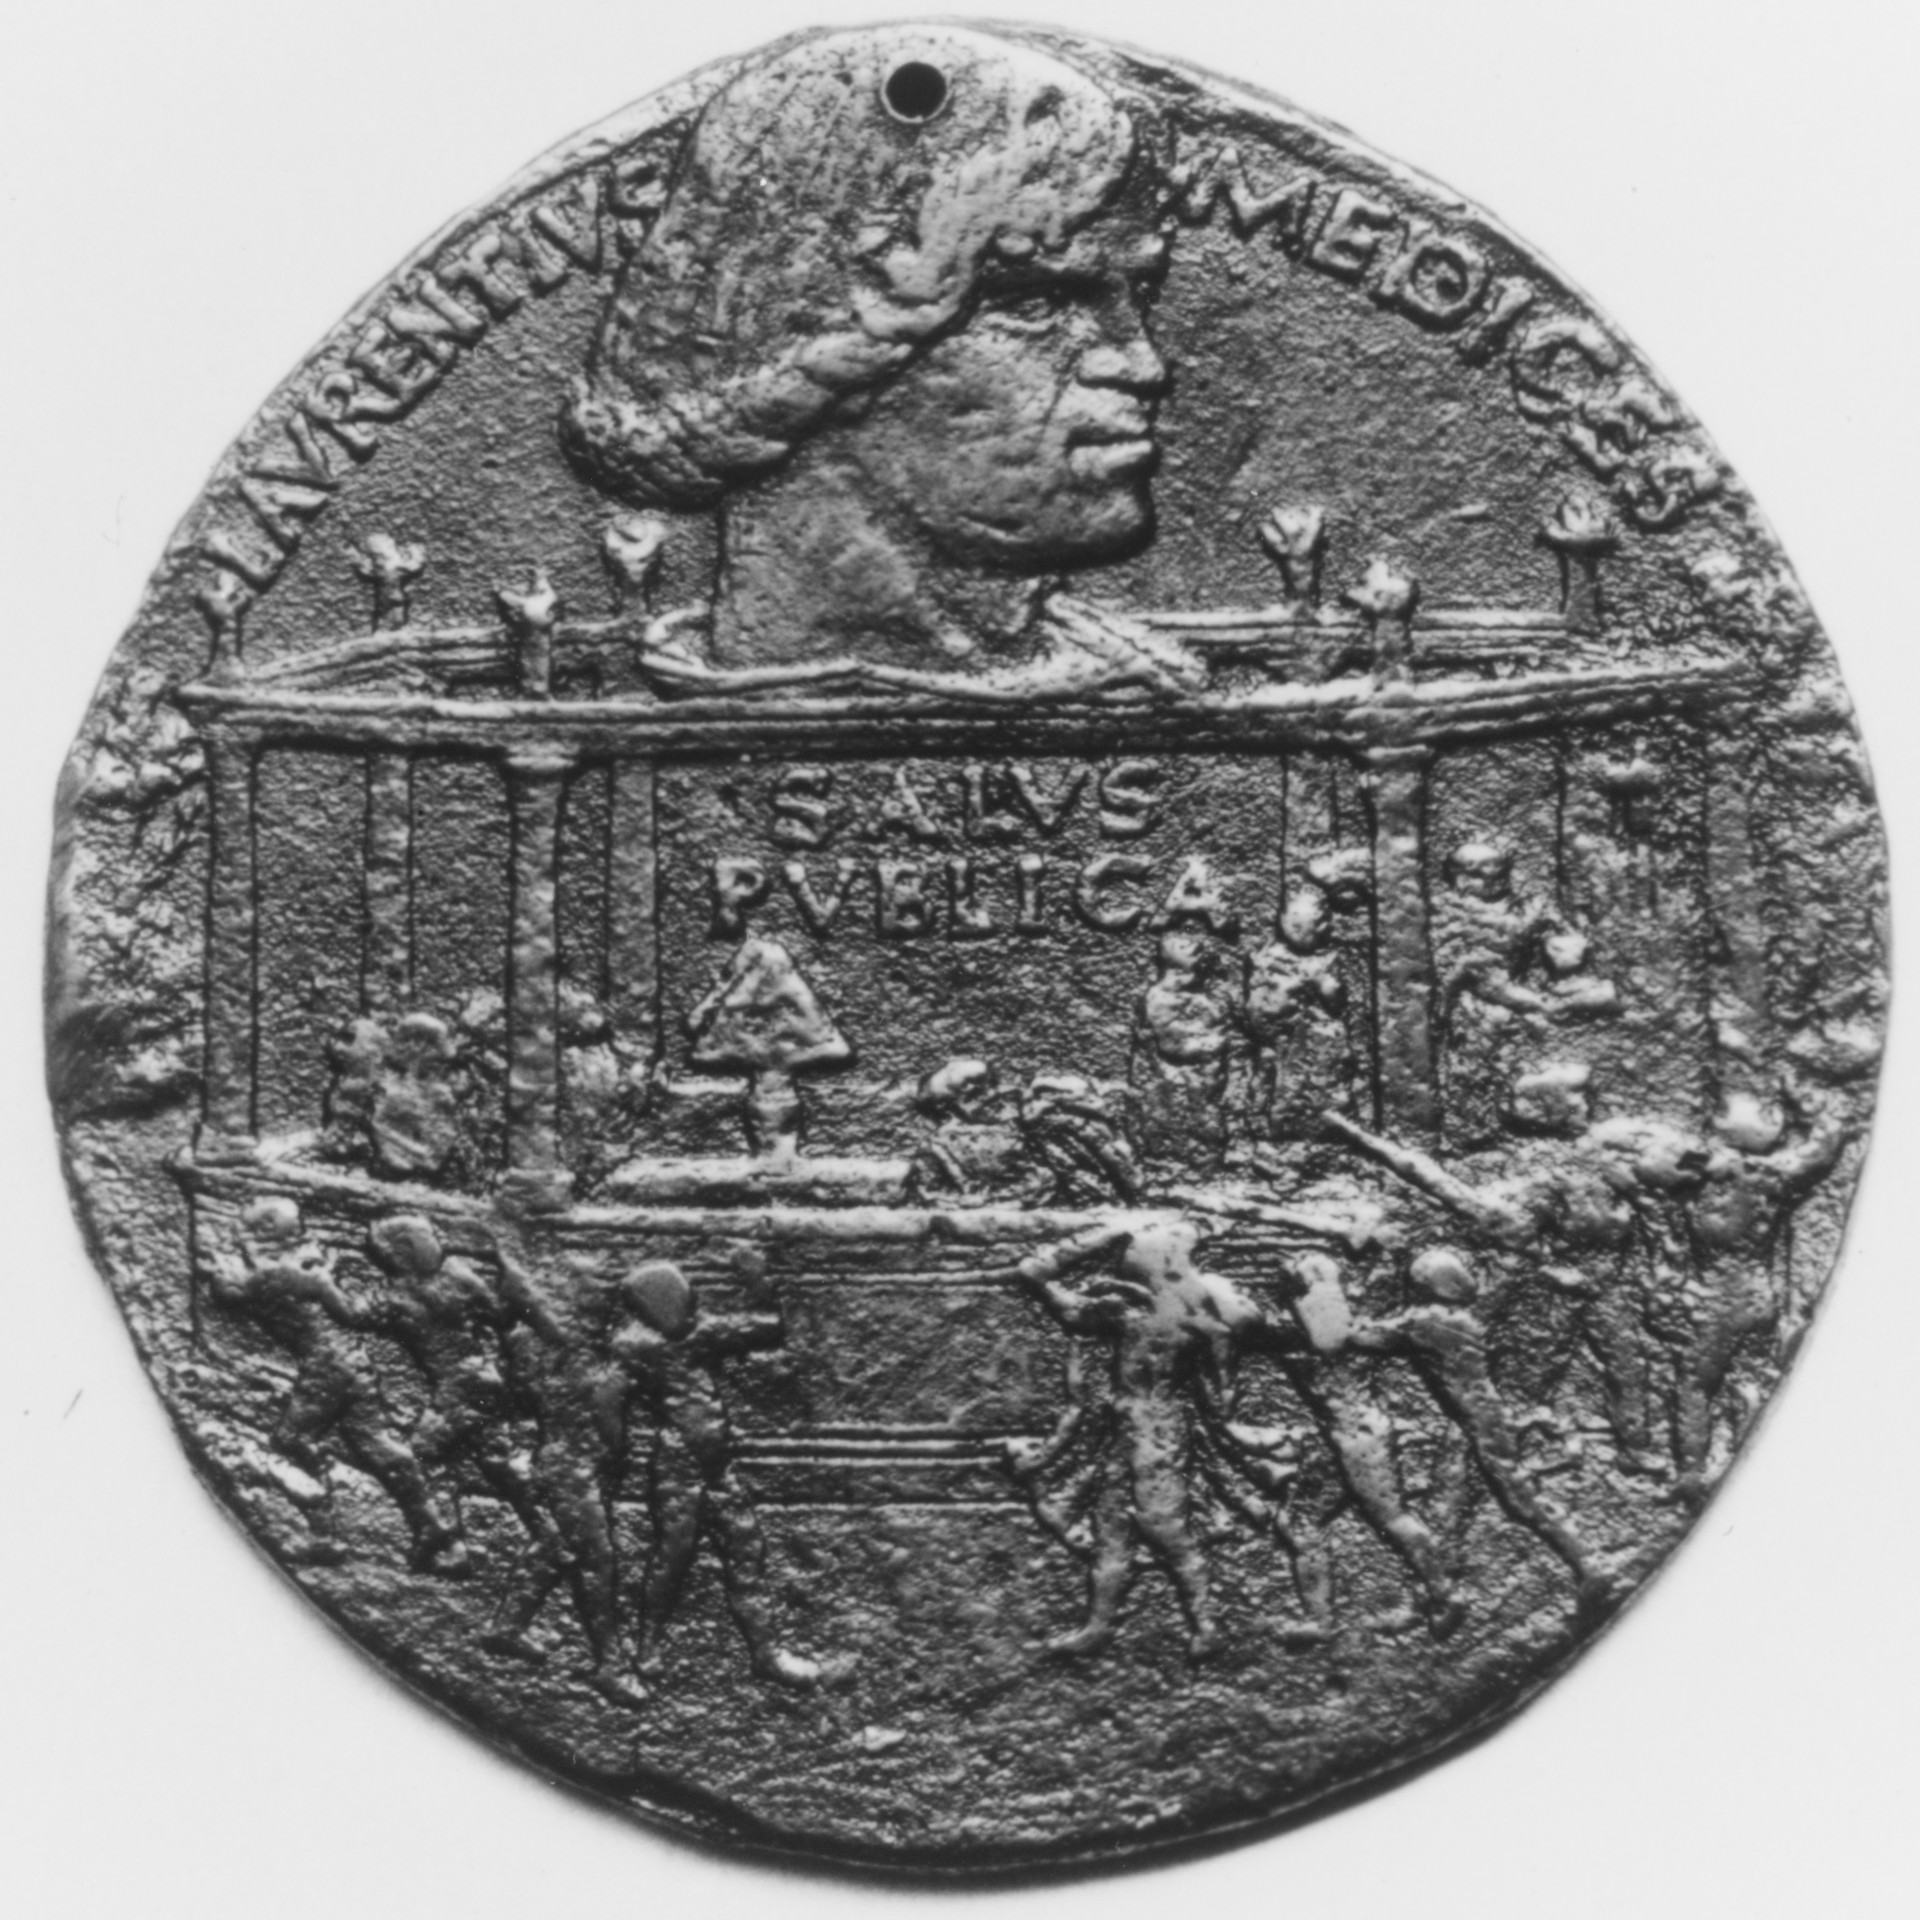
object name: medal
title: To Commemorate the Pazzi Conspiracy, 1478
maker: bertoldo di giovanni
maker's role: artist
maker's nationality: italian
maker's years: 1430-1491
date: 1478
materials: bronze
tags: men,profiles